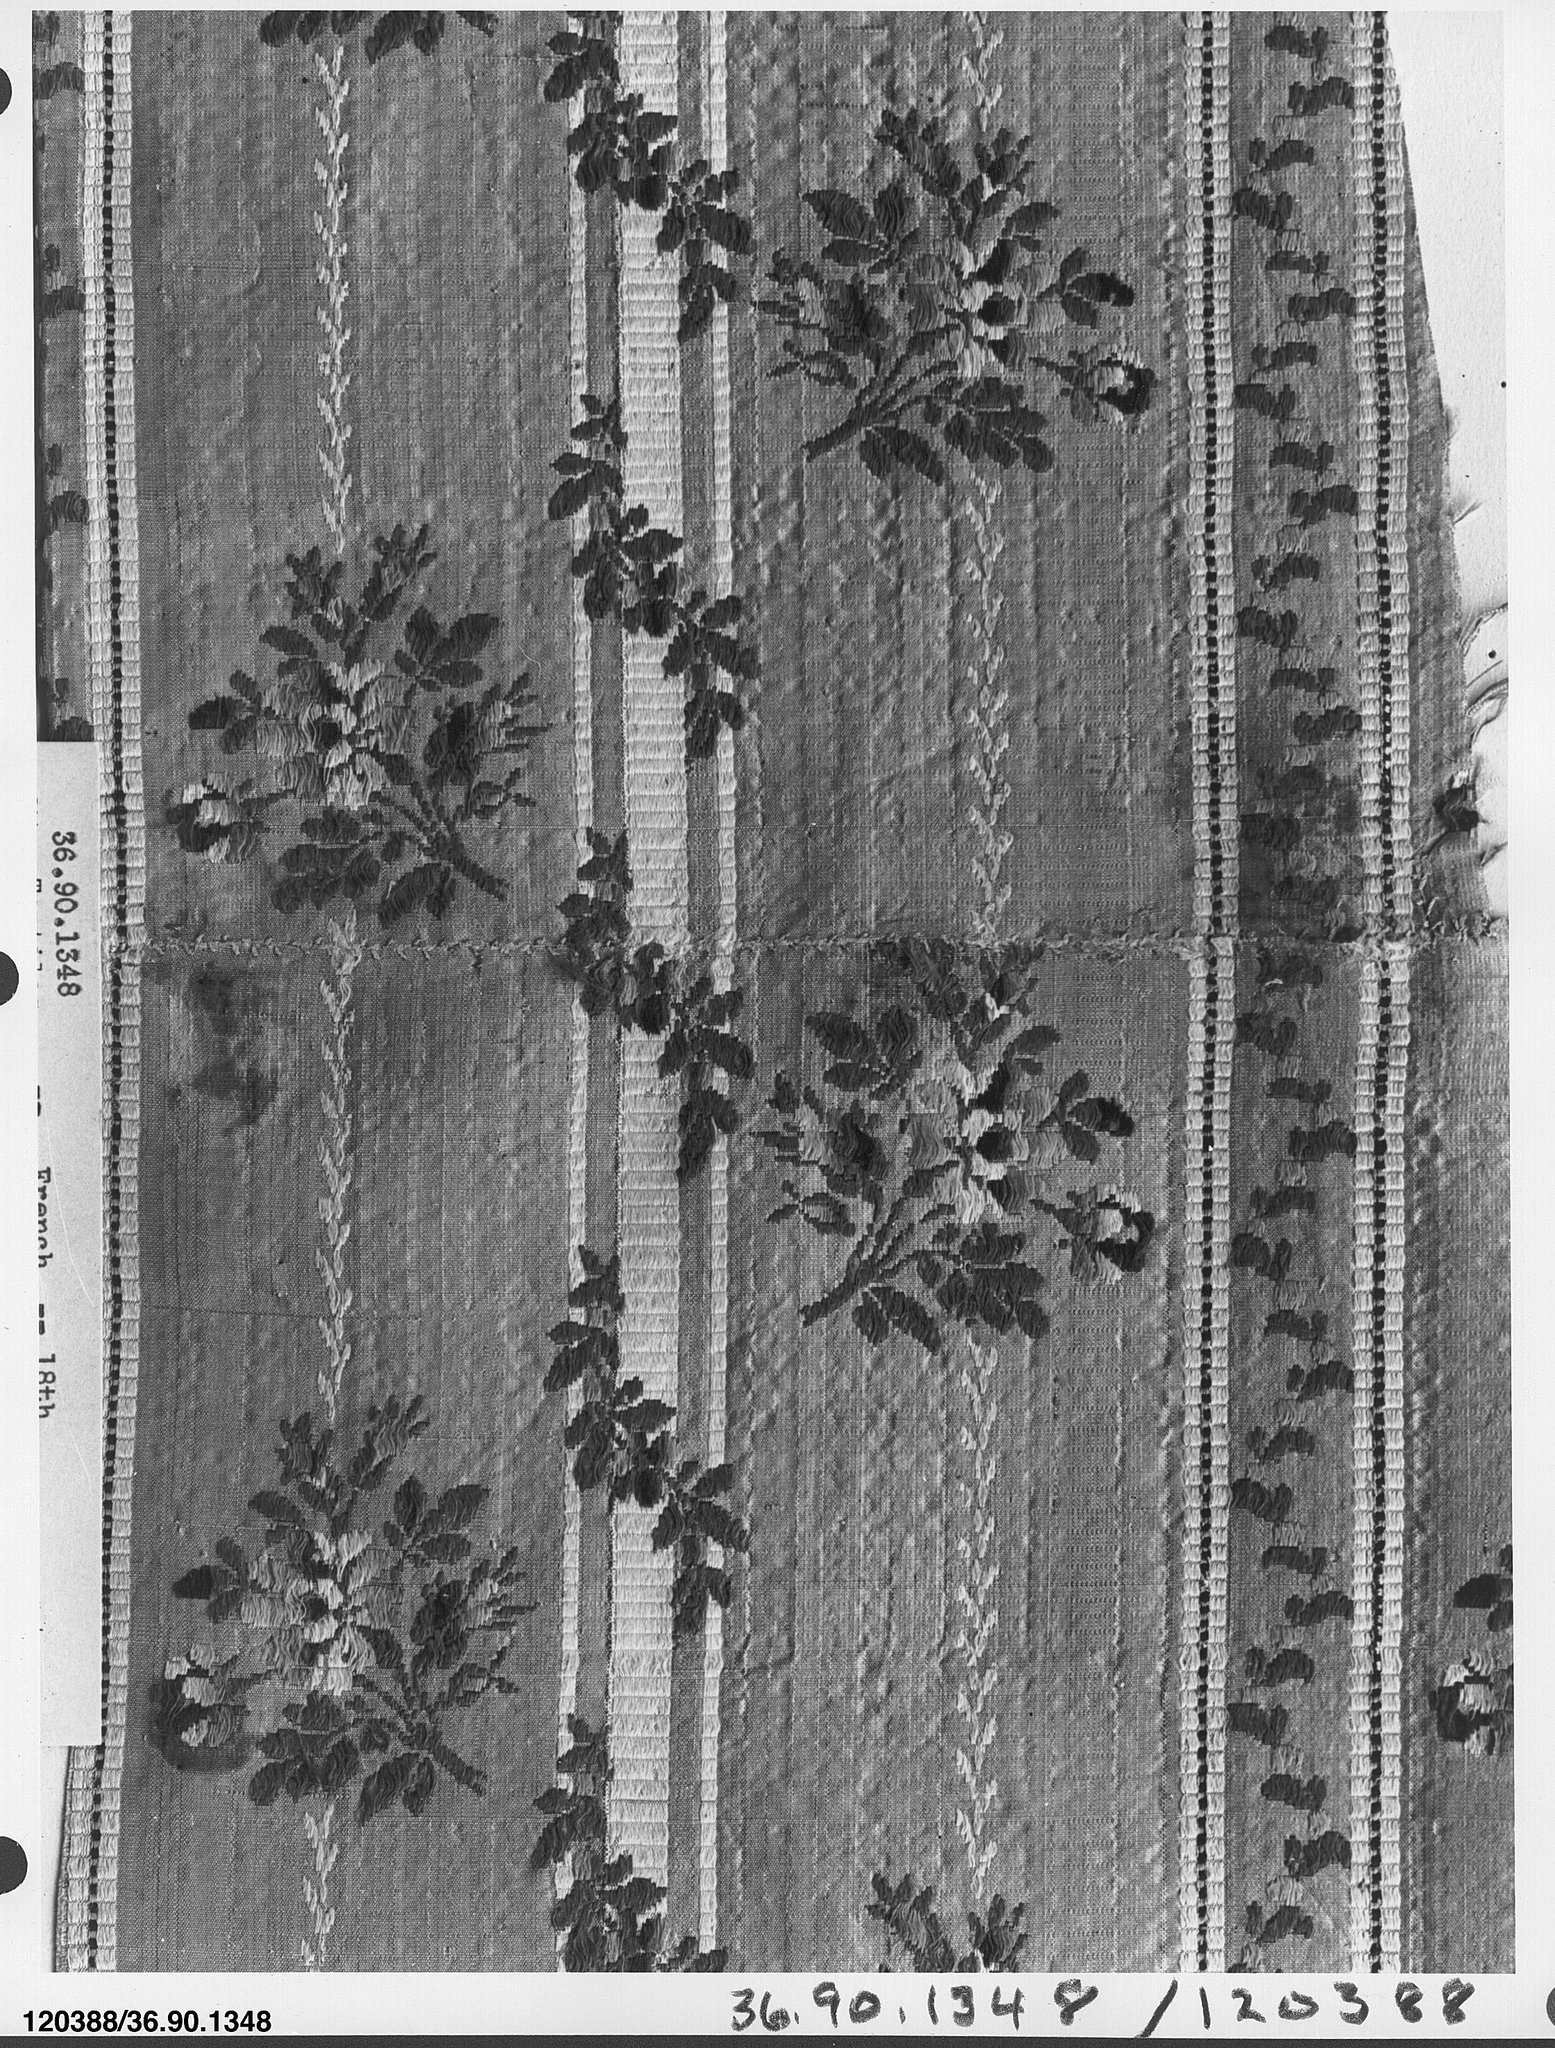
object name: piece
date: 1701-1800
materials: silk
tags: flowers,leaves